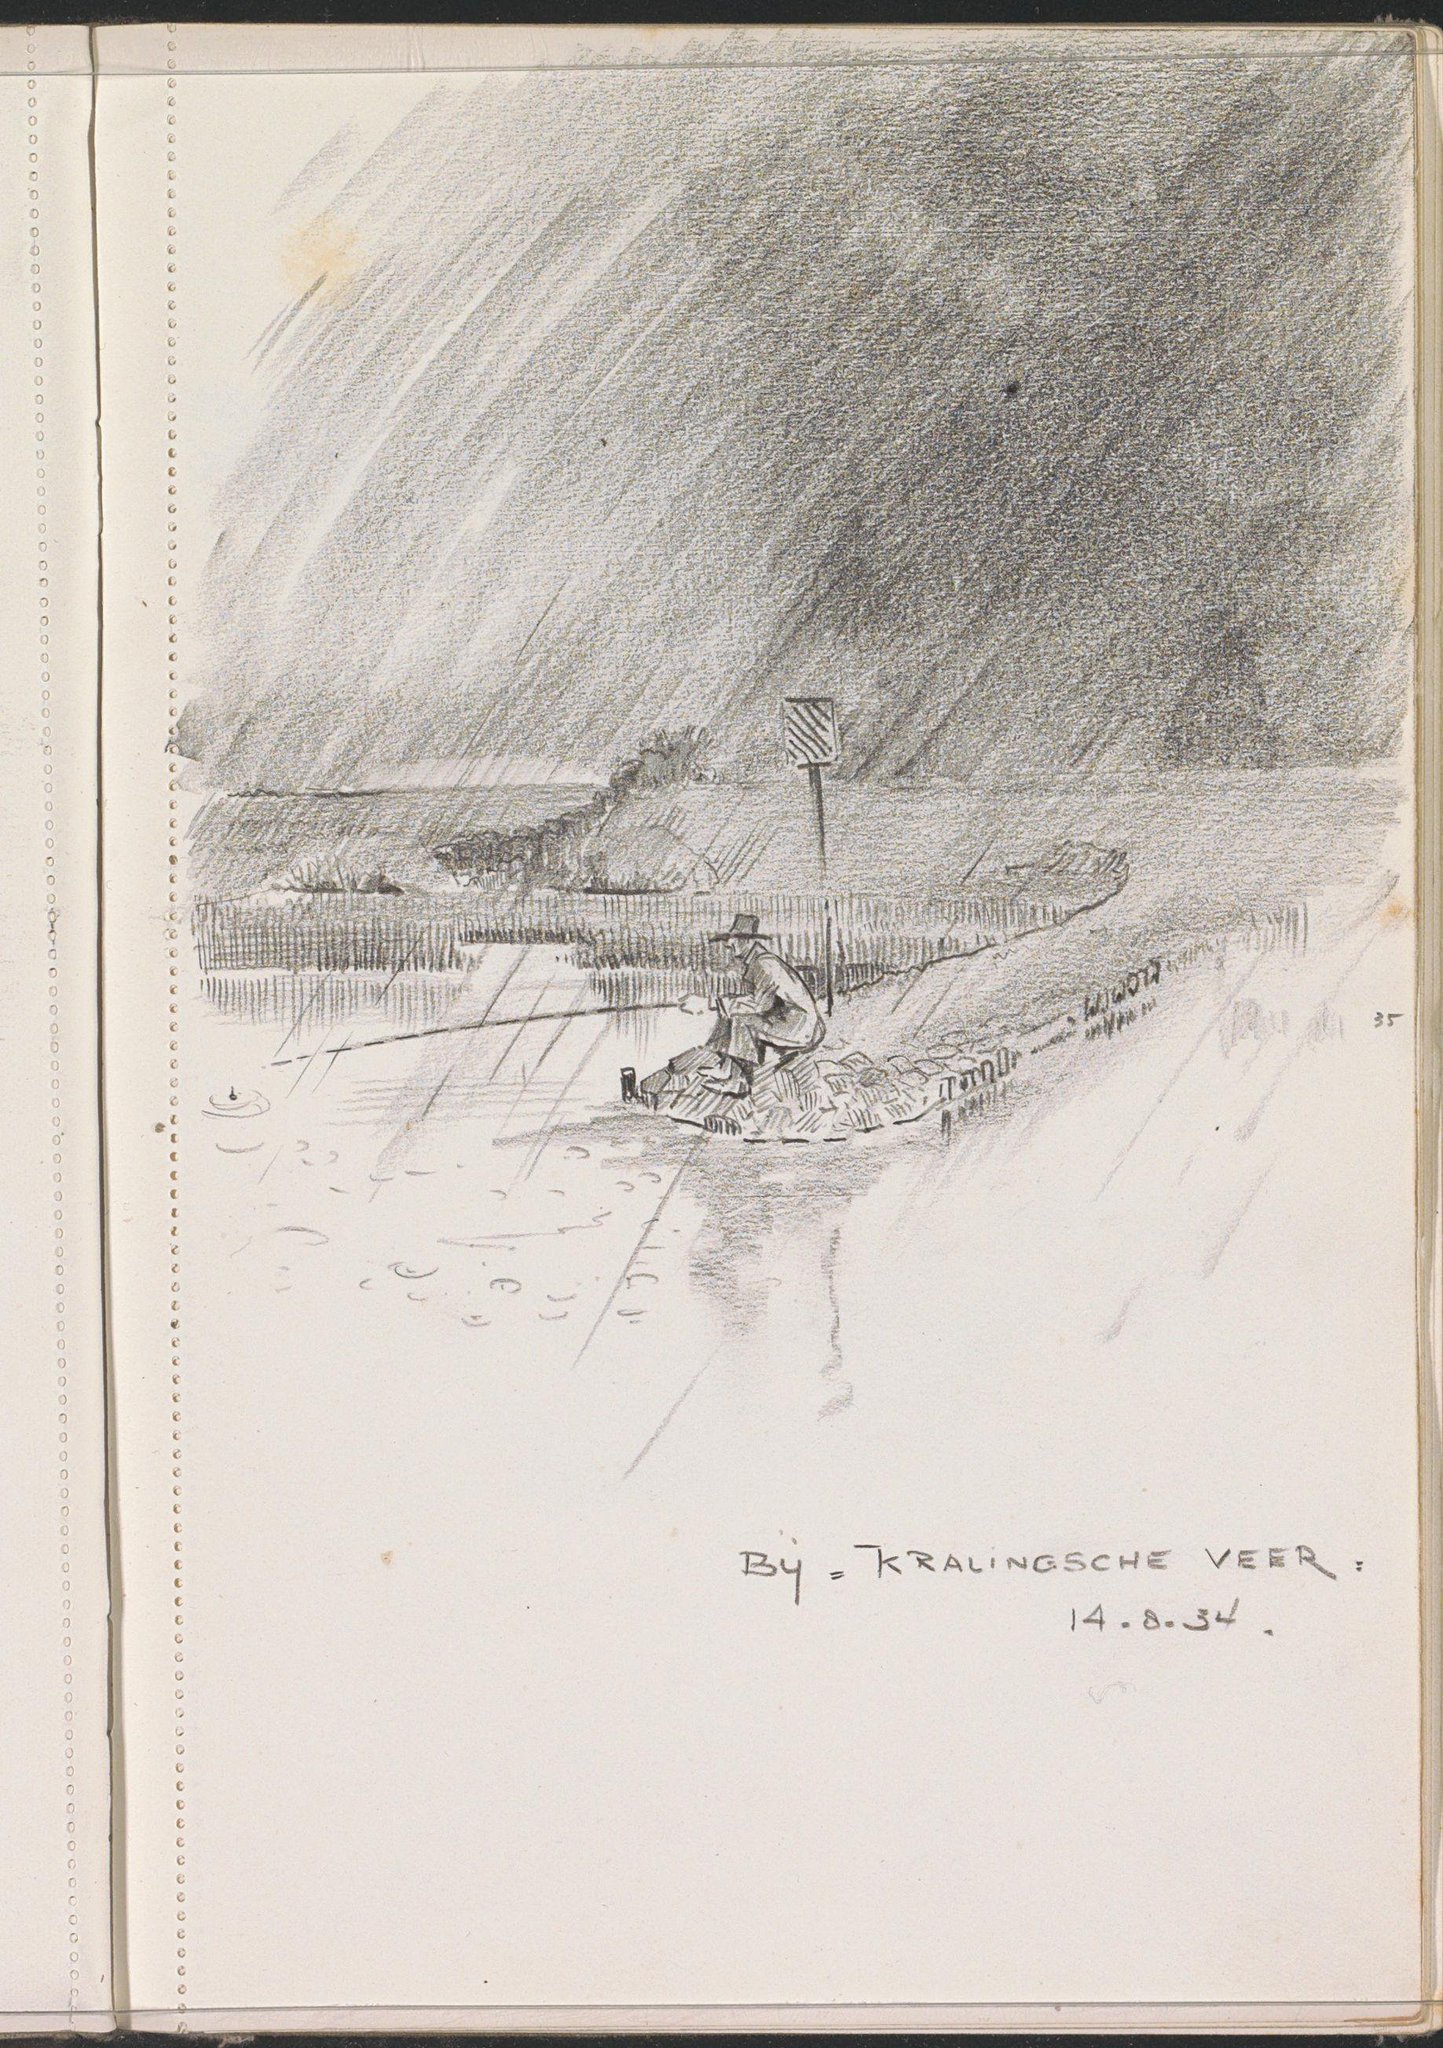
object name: sketchbook leaf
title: Visser aan de Kralingsche Veer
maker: otto verhagen (i)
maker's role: draughtsman, print maker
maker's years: 1885-1951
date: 1908-1934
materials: chalk, paper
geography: rotterdam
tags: rain, fisherman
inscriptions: date and inscription: ‘Bij "Kralingsche Veer"/ 14.8.34.’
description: De man zit op de oever in de regen. Pagina 35 uit een schetsboek met 60 bladen.